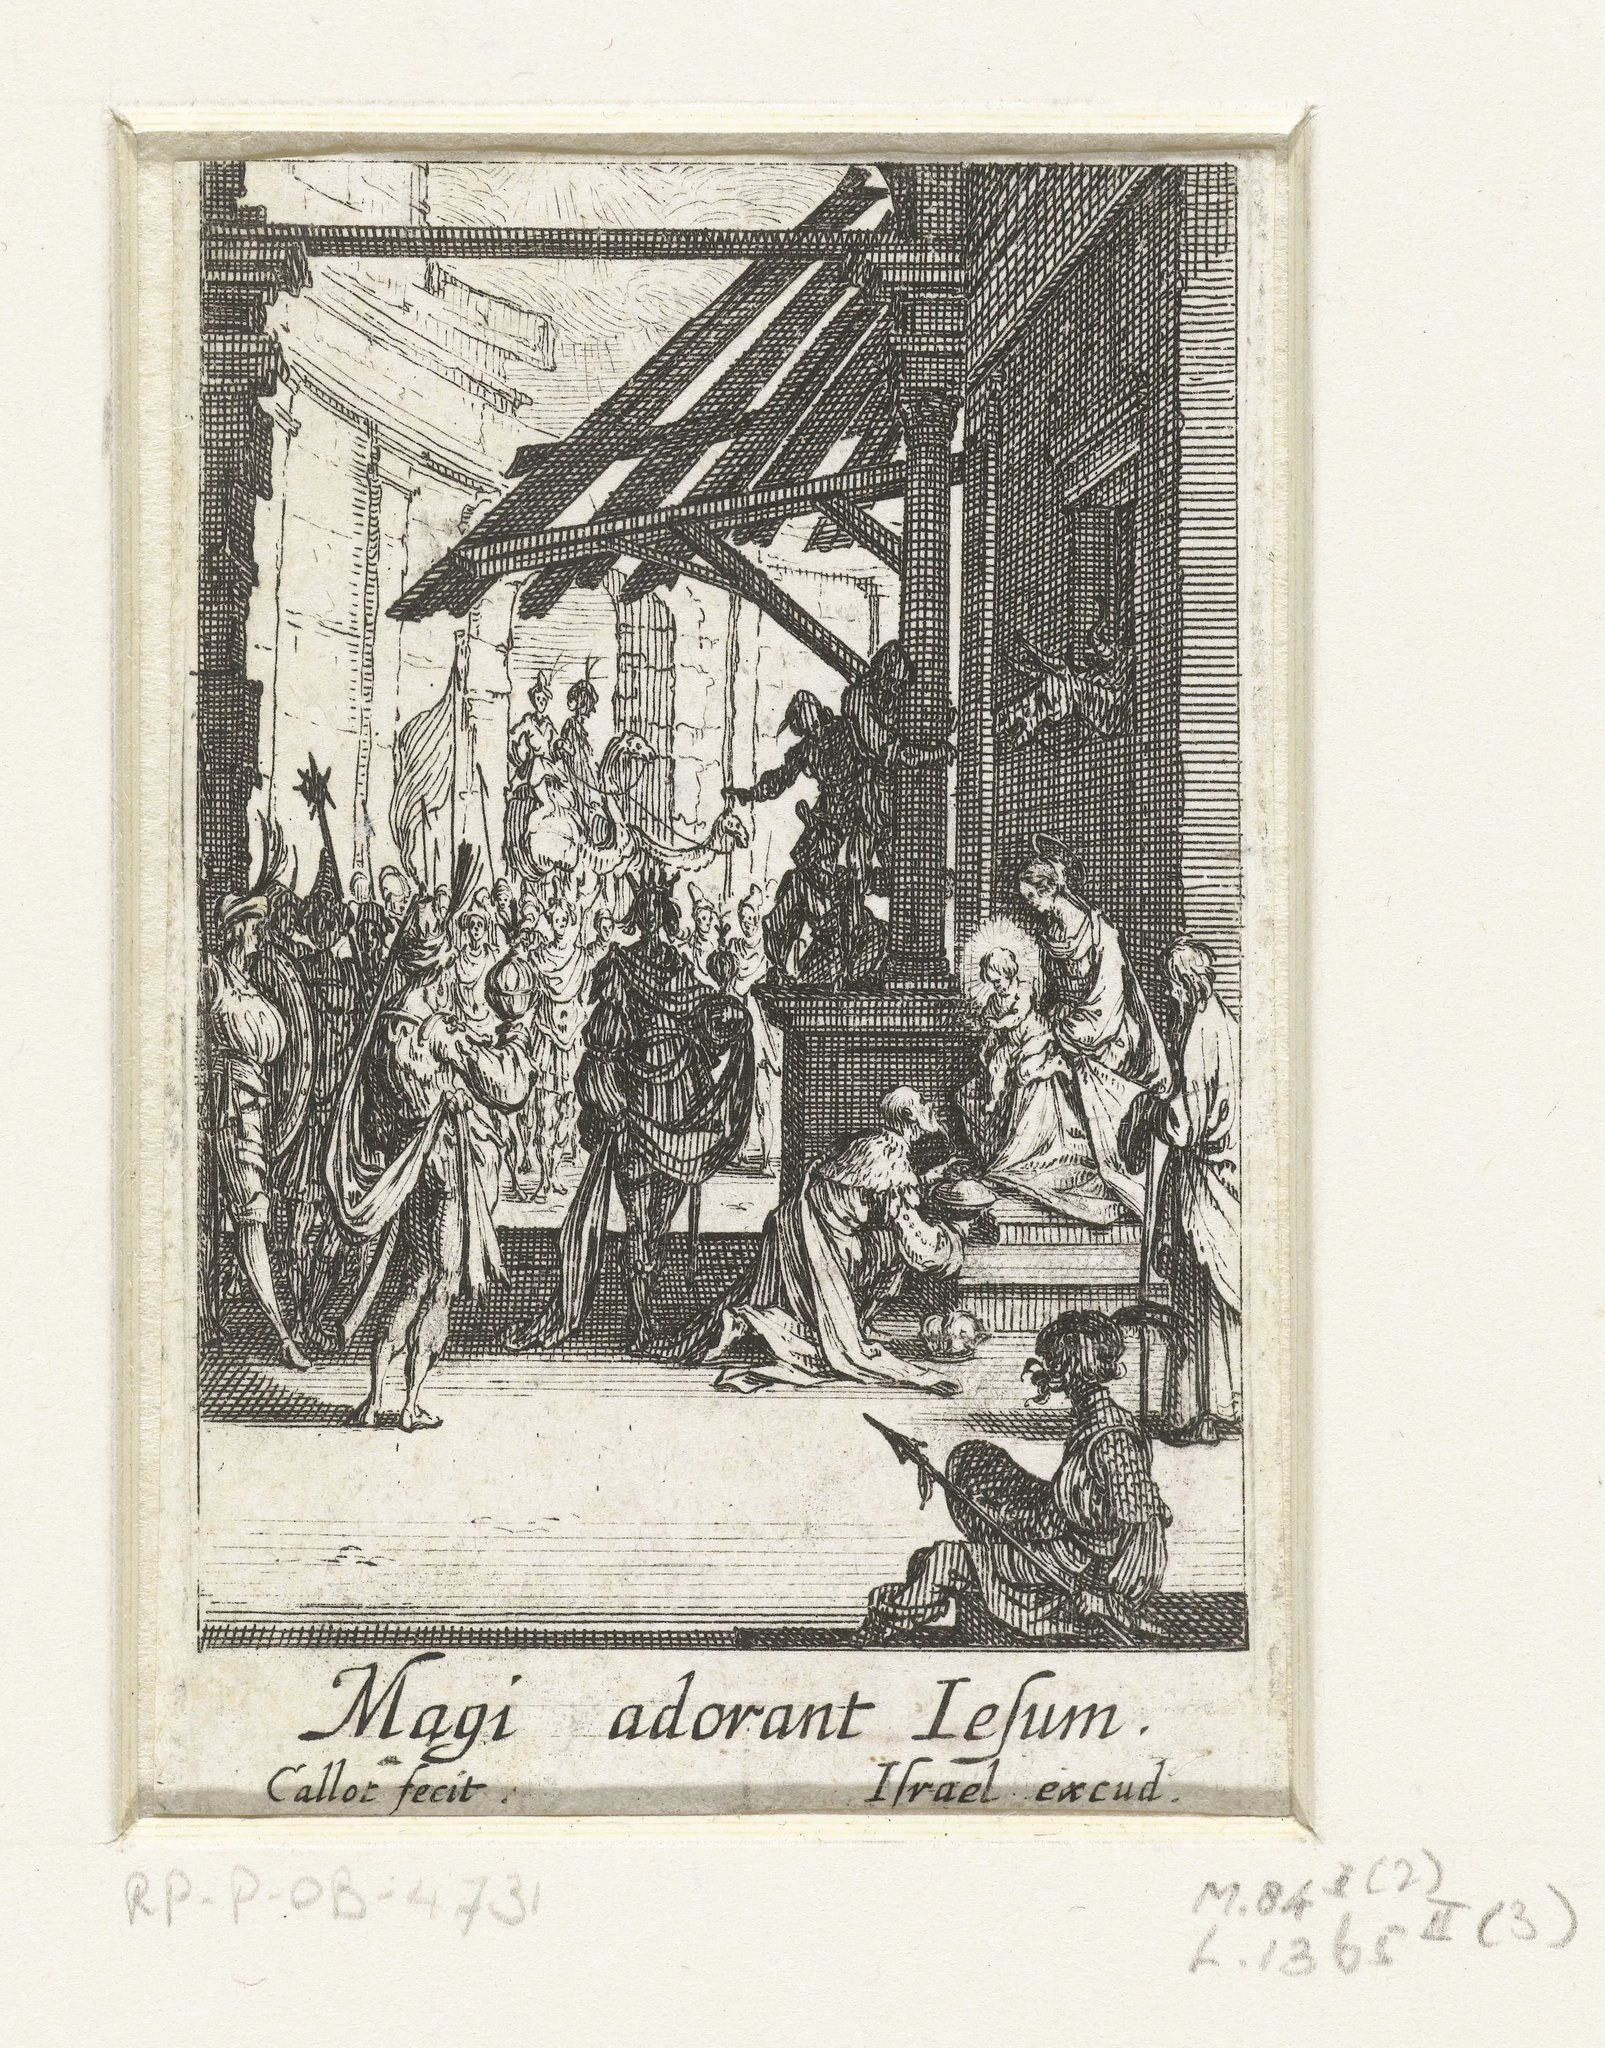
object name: print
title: Aanbidding door de koningen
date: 1633-1634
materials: paper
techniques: etching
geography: paris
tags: adoration of the kings: the wise men present their gifts to the christ-child (gold, frankincense and myrrh)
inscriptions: collector's mark: Lugt 240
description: Maria zit met het Christuskind op schoot bij de ingang van een gebouw. Naast haar staat Jozef. De drie koningen of wijzen uit het Oosten bieden Christus hun geschenken aan. Onder de voorstelling een onderschrift in Latijn. Deze prent is onderdeel van een reeks prenten rond het leven van Maria, bestaande uit een titelprent en dertien verhalende voorstellingen.